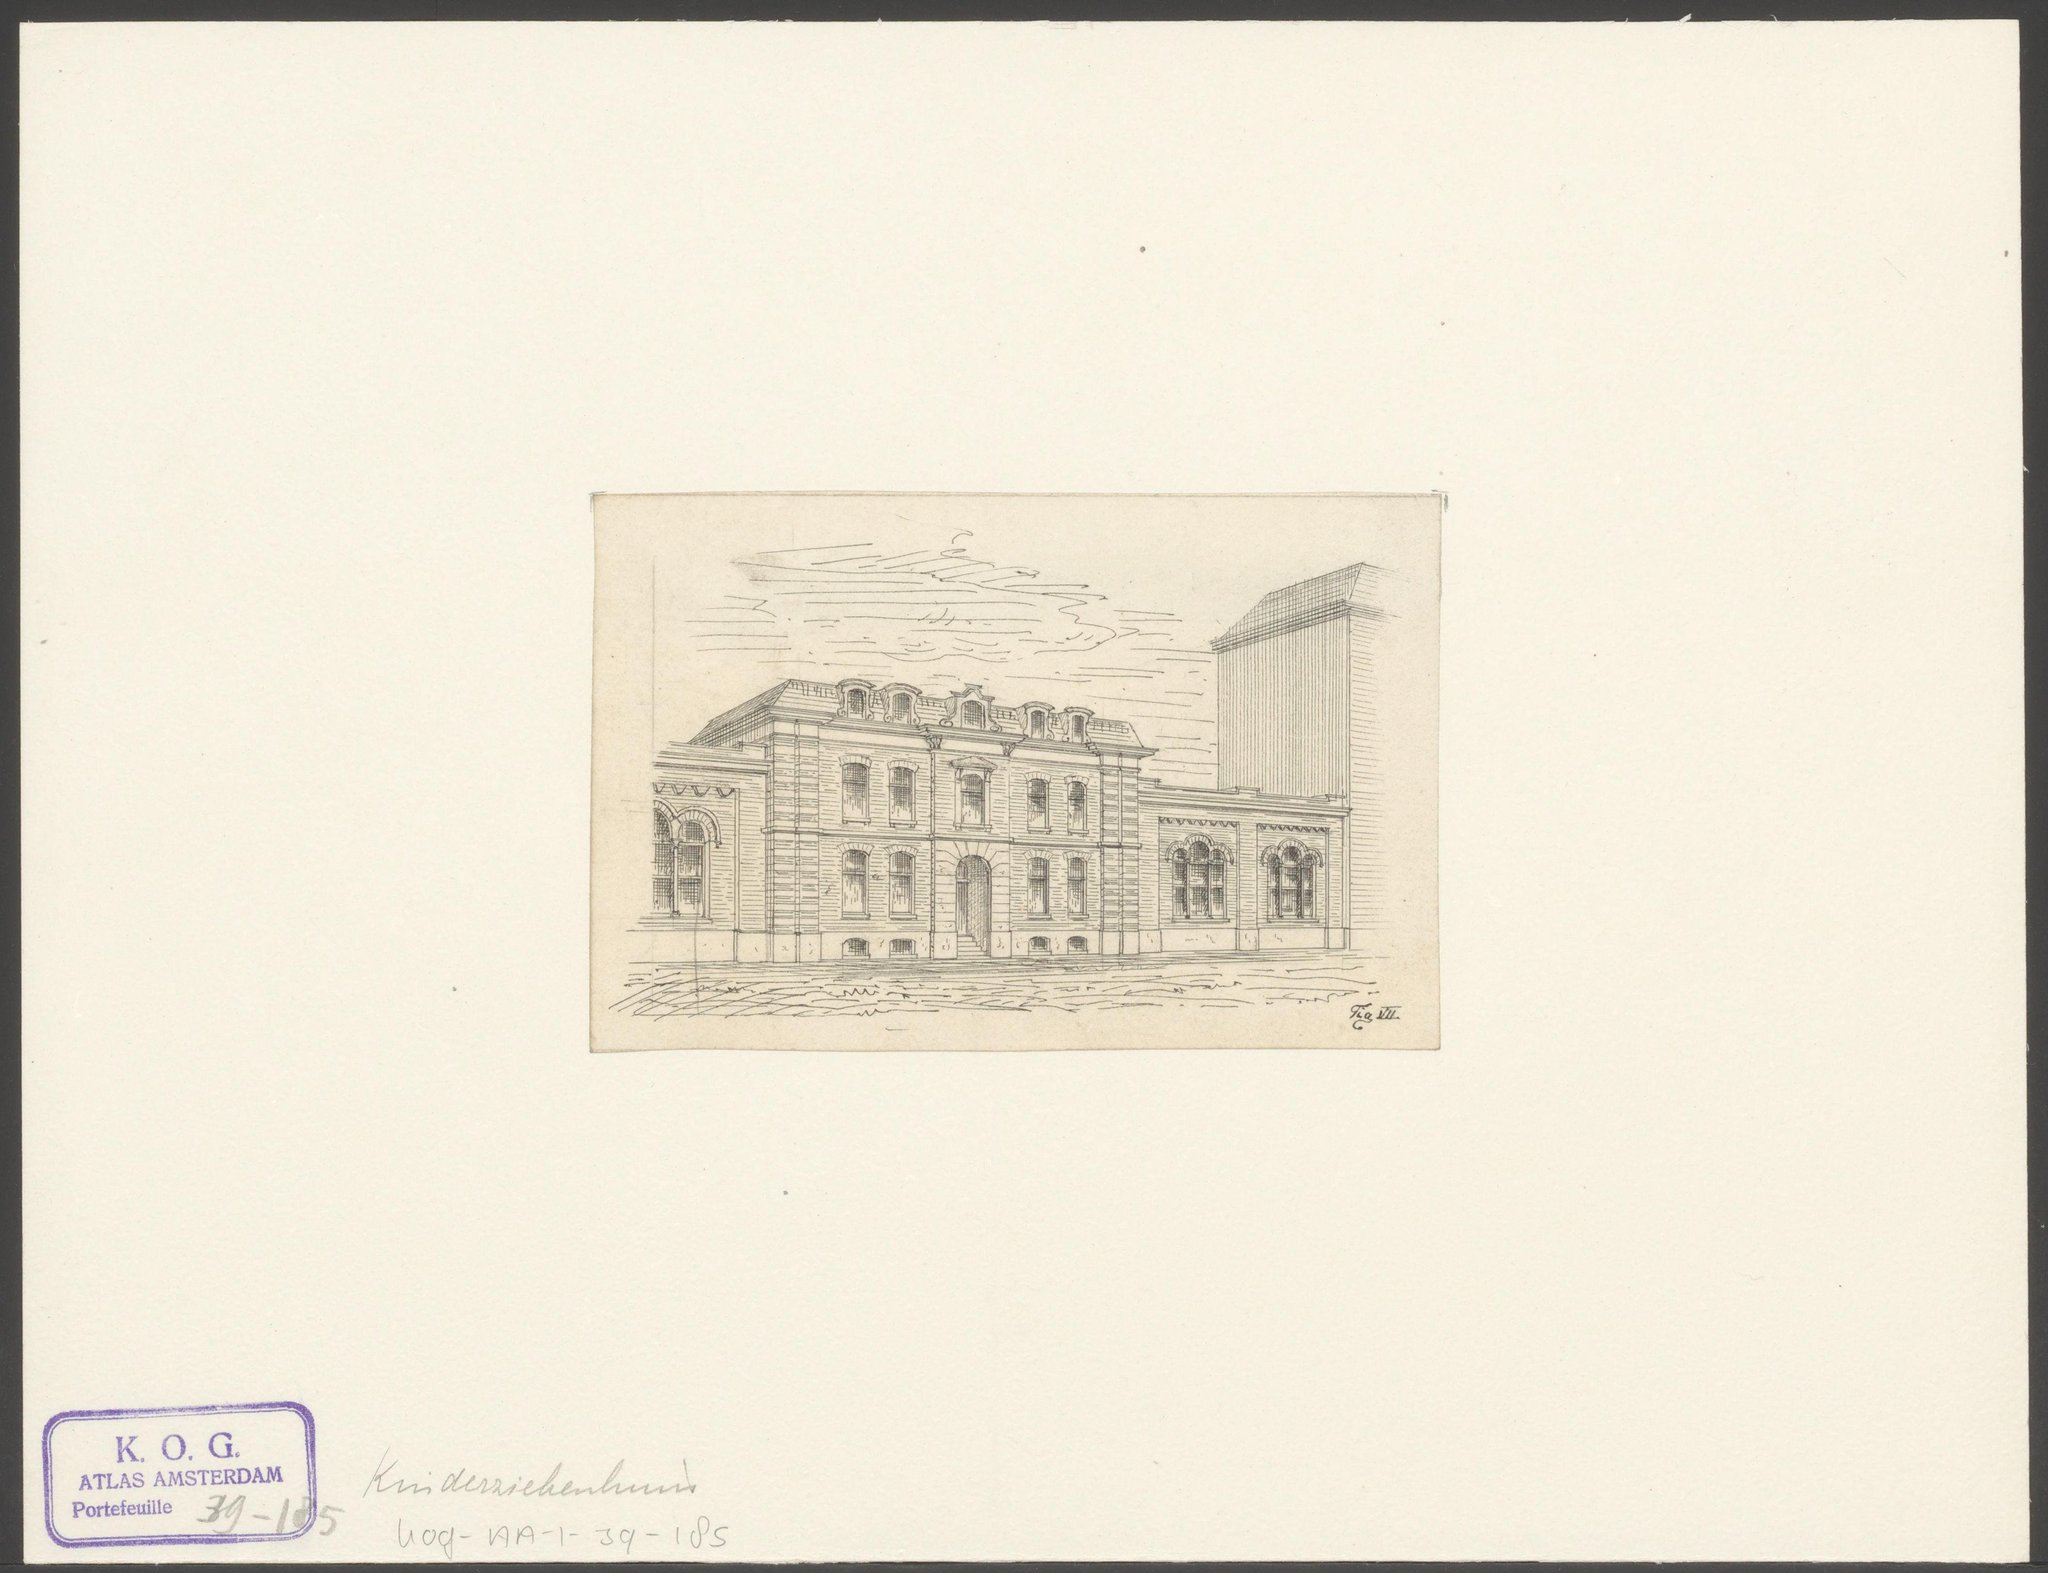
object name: drawing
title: Gezicht op het kinderziekenhuis in de Sarphatistraat te Amsterdam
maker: Anonymous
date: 1873-1885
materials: ink, paper, pencil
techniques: pen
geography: netherlands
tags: hospital, street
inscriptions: collector's mark: Lugt 1641b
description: Rechtsonder gemerkt: Fig VII. Onderwerpsrubriek binnen de Atlas Amsterdam: Armwezen en liefdadige instellingen: V. Ziekenhuizen: Kinderziekenhuis Sarphatistraat - Luth. Diaconessen Inrichting.